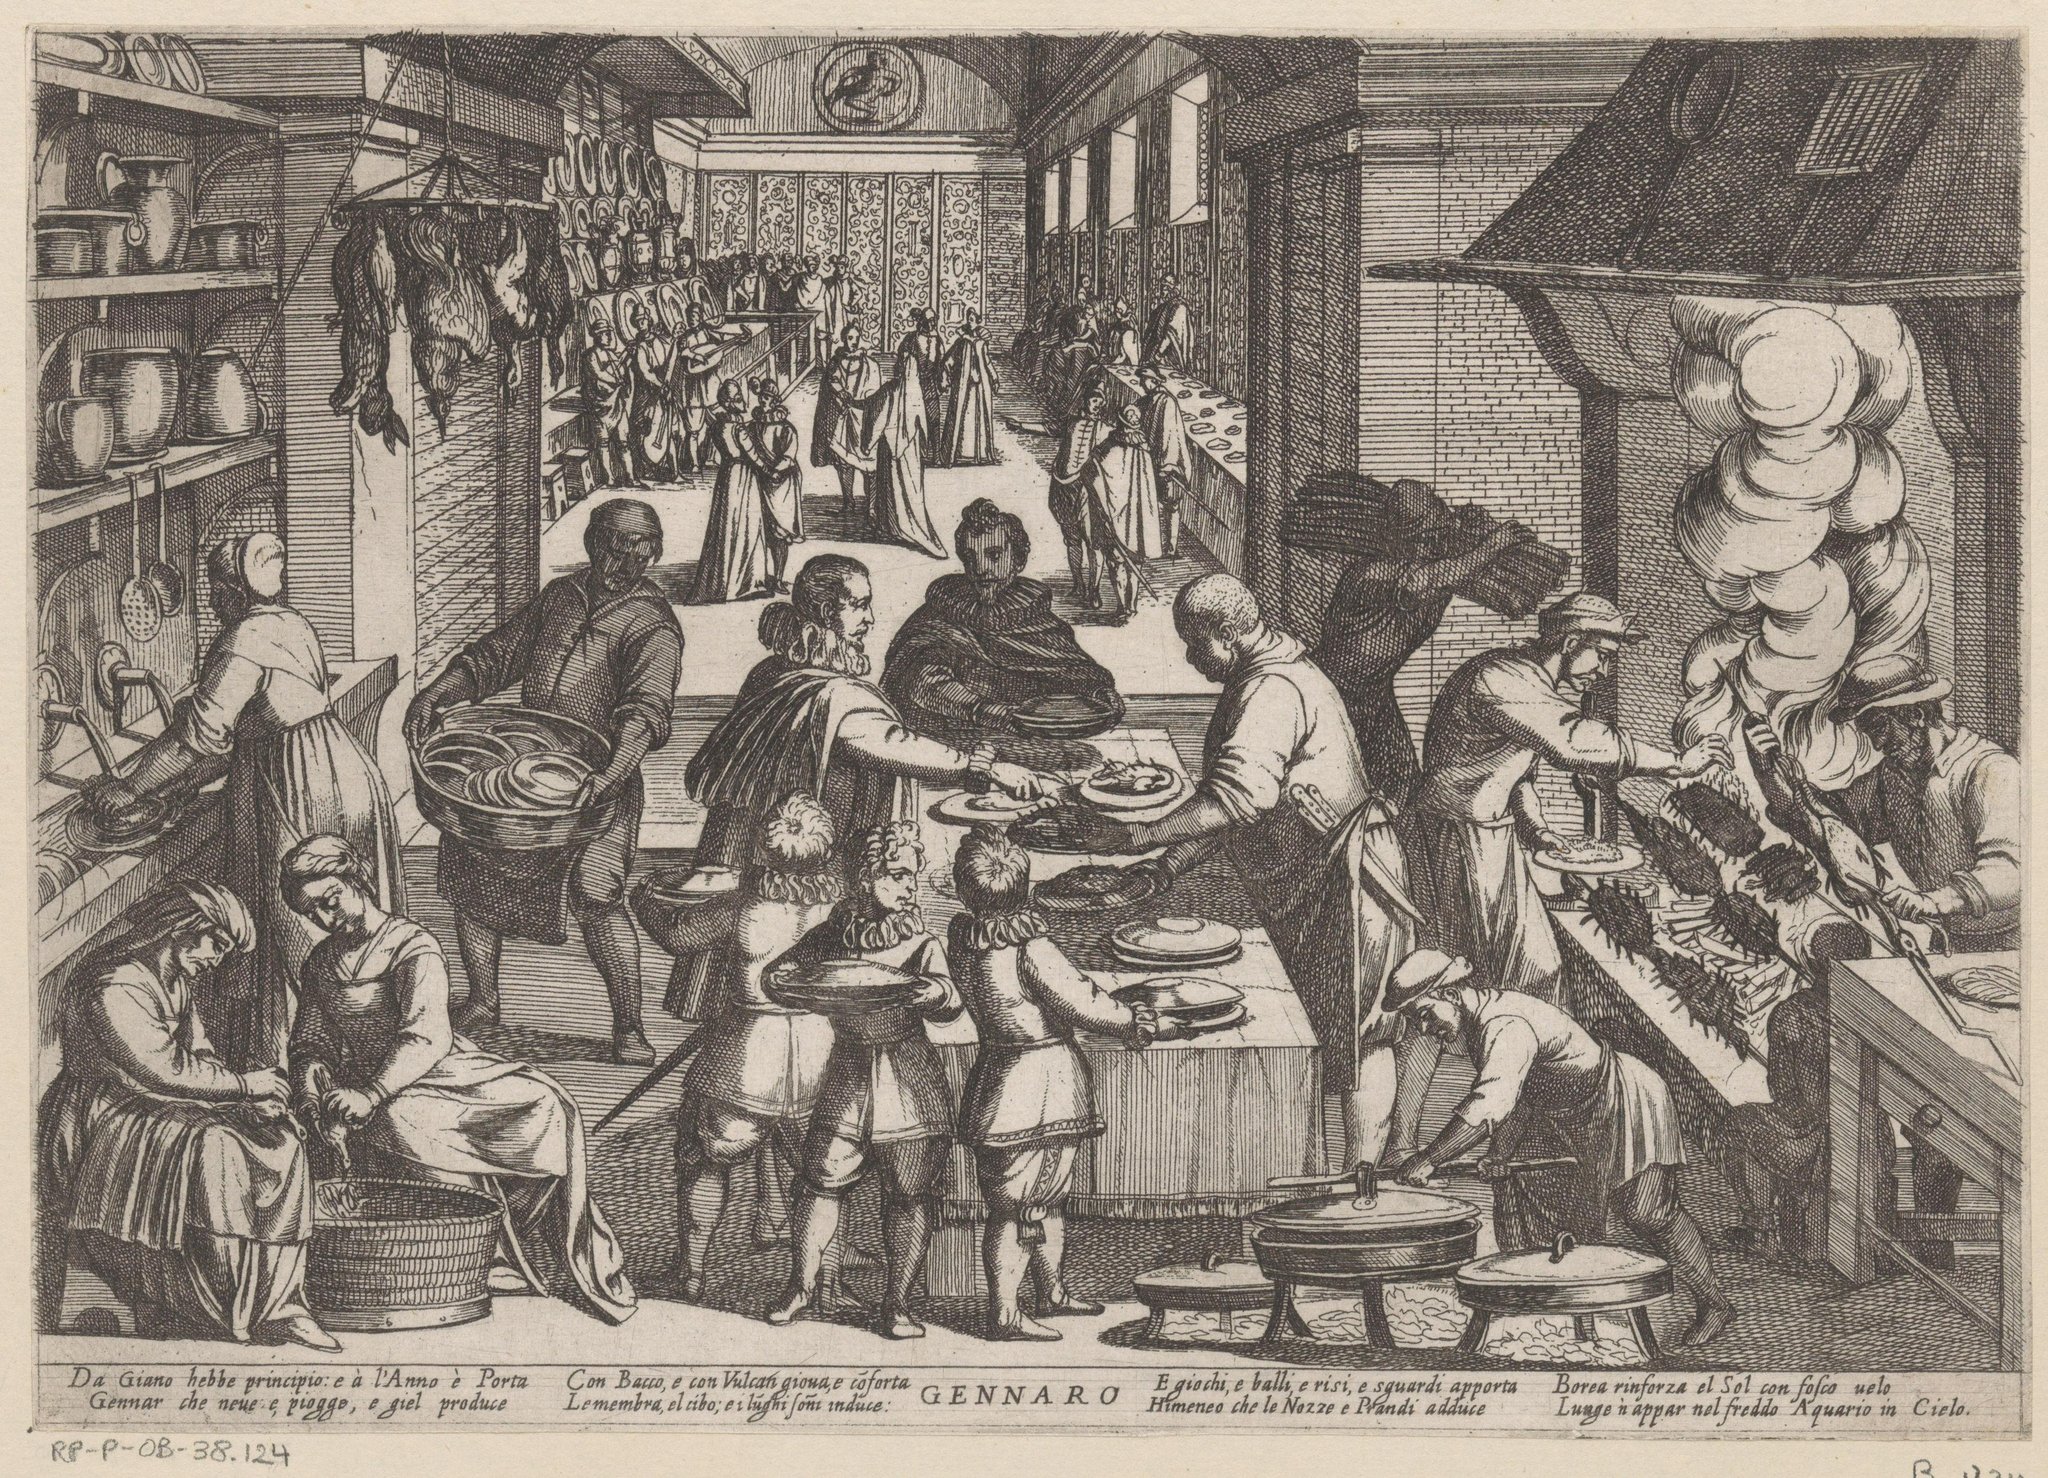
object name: print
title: Januari: een keuken (waterman)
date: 1599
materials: paper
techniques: etching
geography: italy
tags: the twelve months represented by scenes showing human activities, usually in a landscape; so-called 'labours of the months', kitchen-interior, aquarius (zodiacal sign of january)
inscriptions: collector's mark: Lugt 240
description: Verbeelding van menselijke activiteit in de maand januari. Gezicht in een drukke keuken waar eten wordt bereid en de afwas wordt gedaan. Midden boven het symbool voor het sterrenbeeld waterman. Italiaans vers en titel in ondermarge.